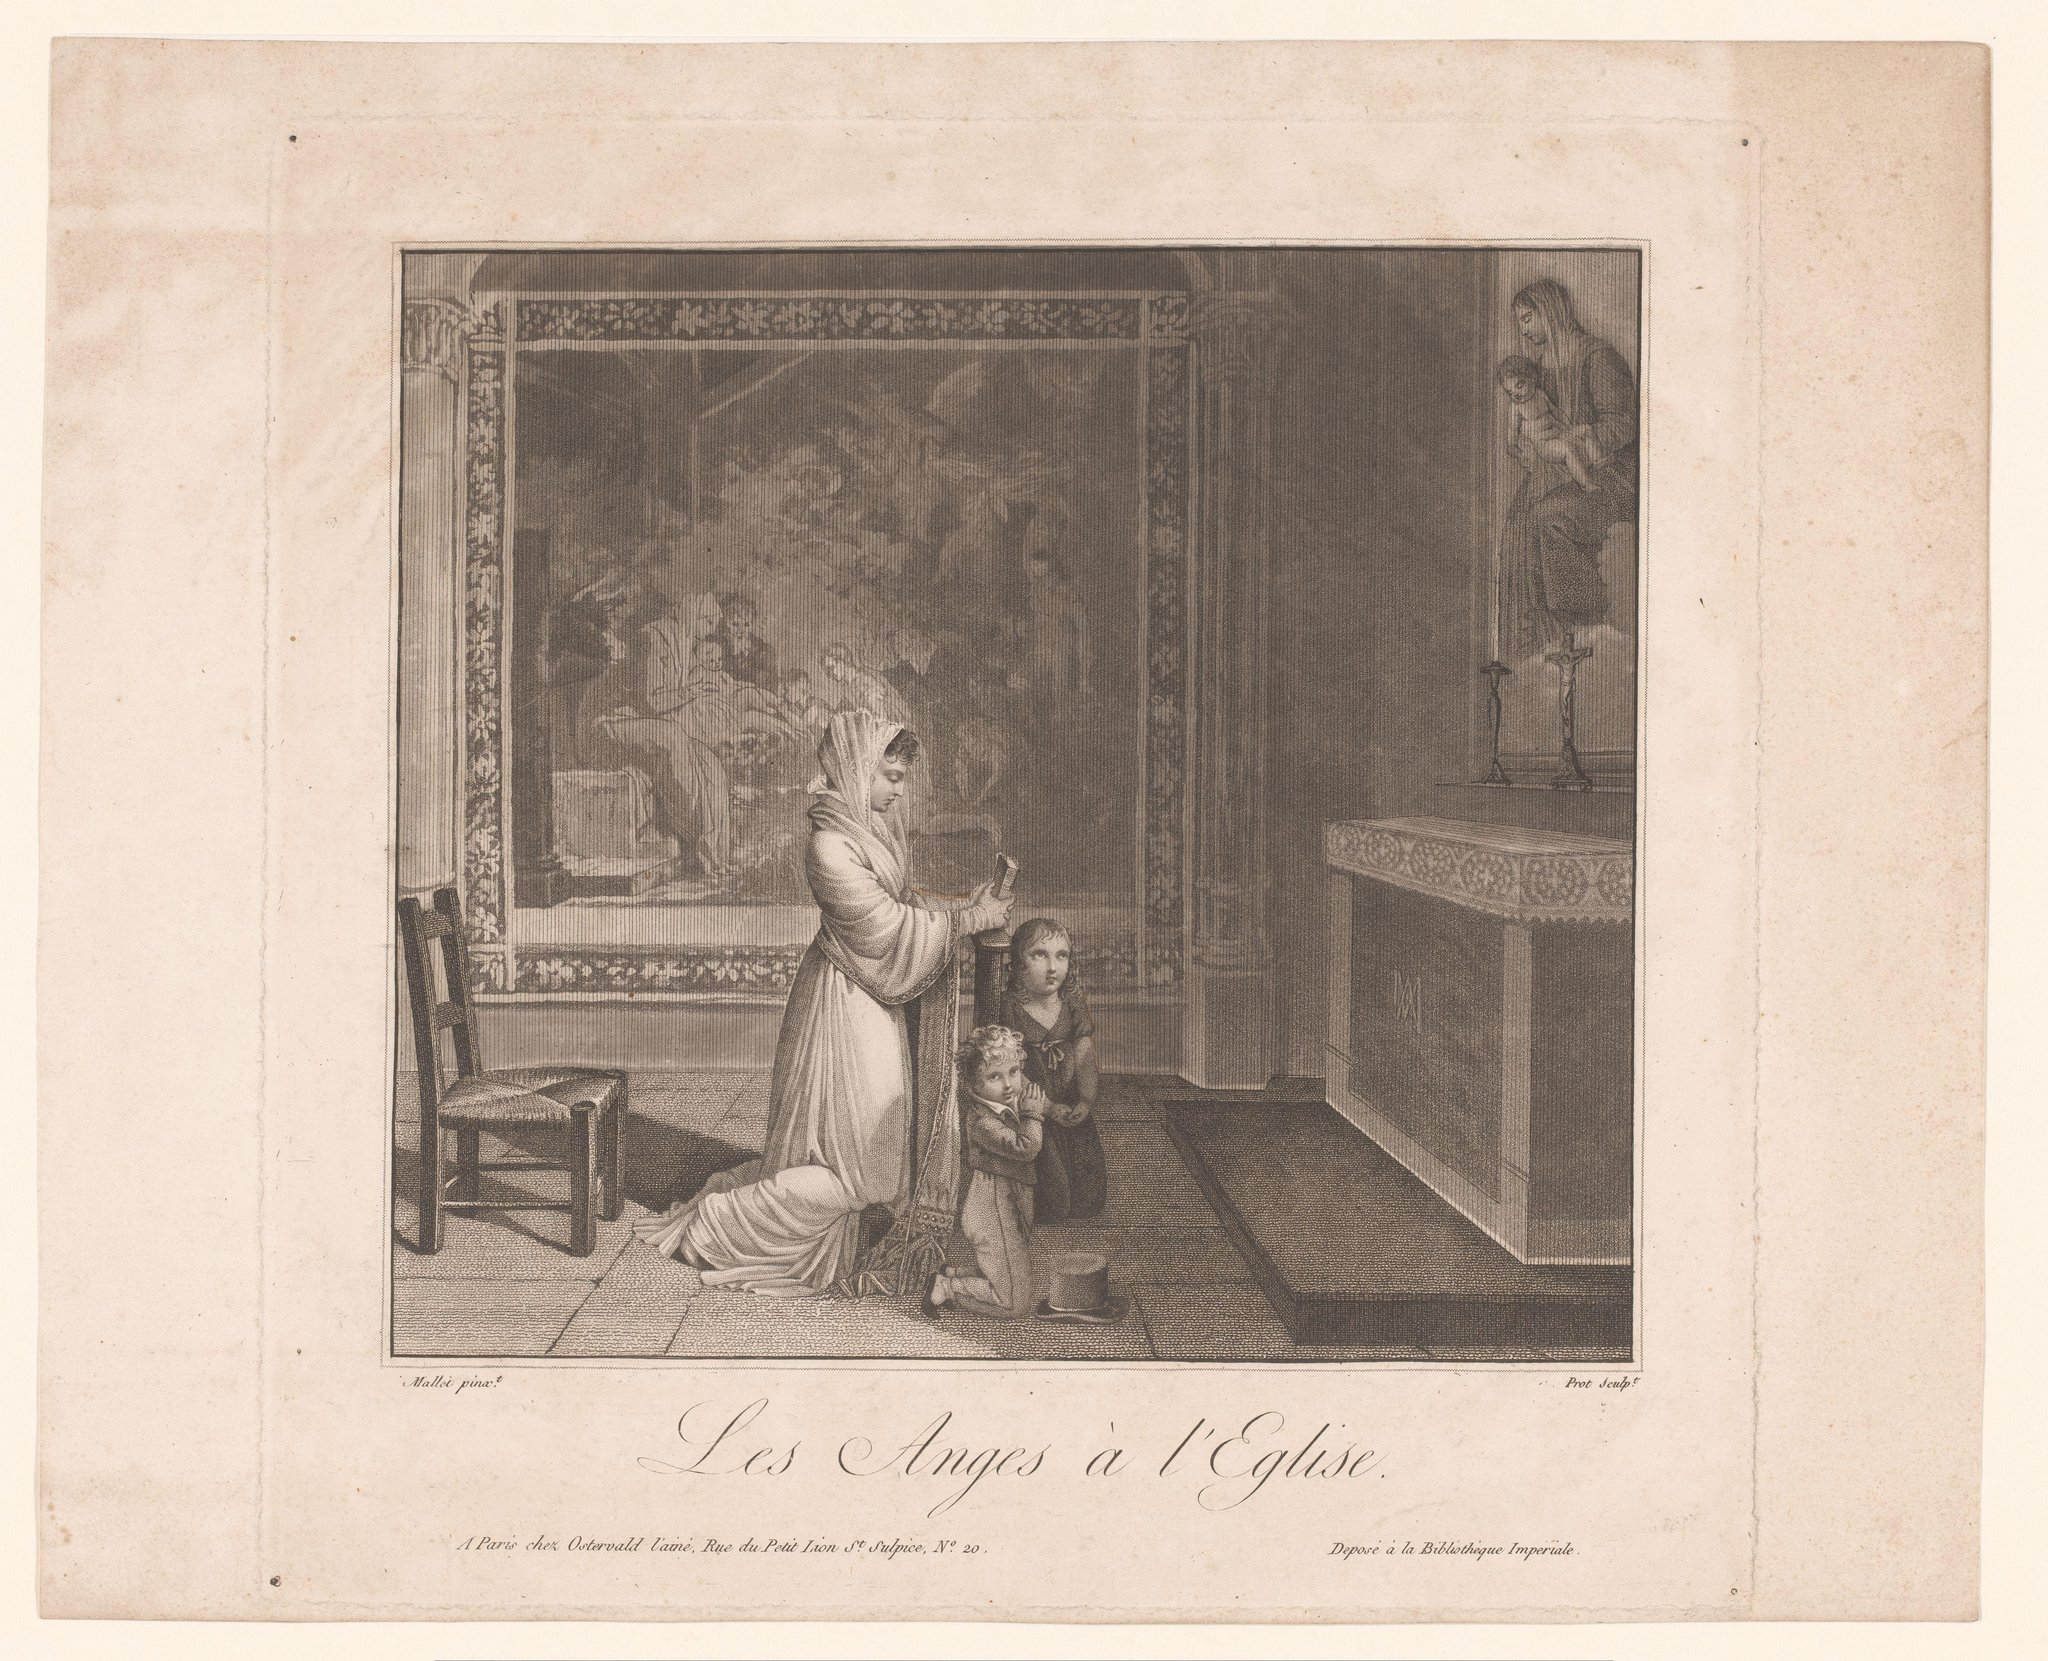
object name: print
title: Les Anges à l'Eglise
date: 1807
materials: paper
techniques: aquatint, etching, pen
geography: paris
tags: missal, (private) prayer; 'oratione', 'preghiere', 'preghiere a dio' (ripa), parts of church interior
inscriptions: : ‘Déposé à la Bibliothèque Impériale’, collector's mark: Lugt 2760, collector's mark: Lugt 2228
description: Een jonge vrouw knielt op een bidstoel voor een Maria-altaar. Rechts van haar een knielend jong meisje; links een knielend jongetje dat de beschouwer recht aankijkt. In de achtergrond is een gobelin weergegeven met de voorstelling van de aanbidding der herders.